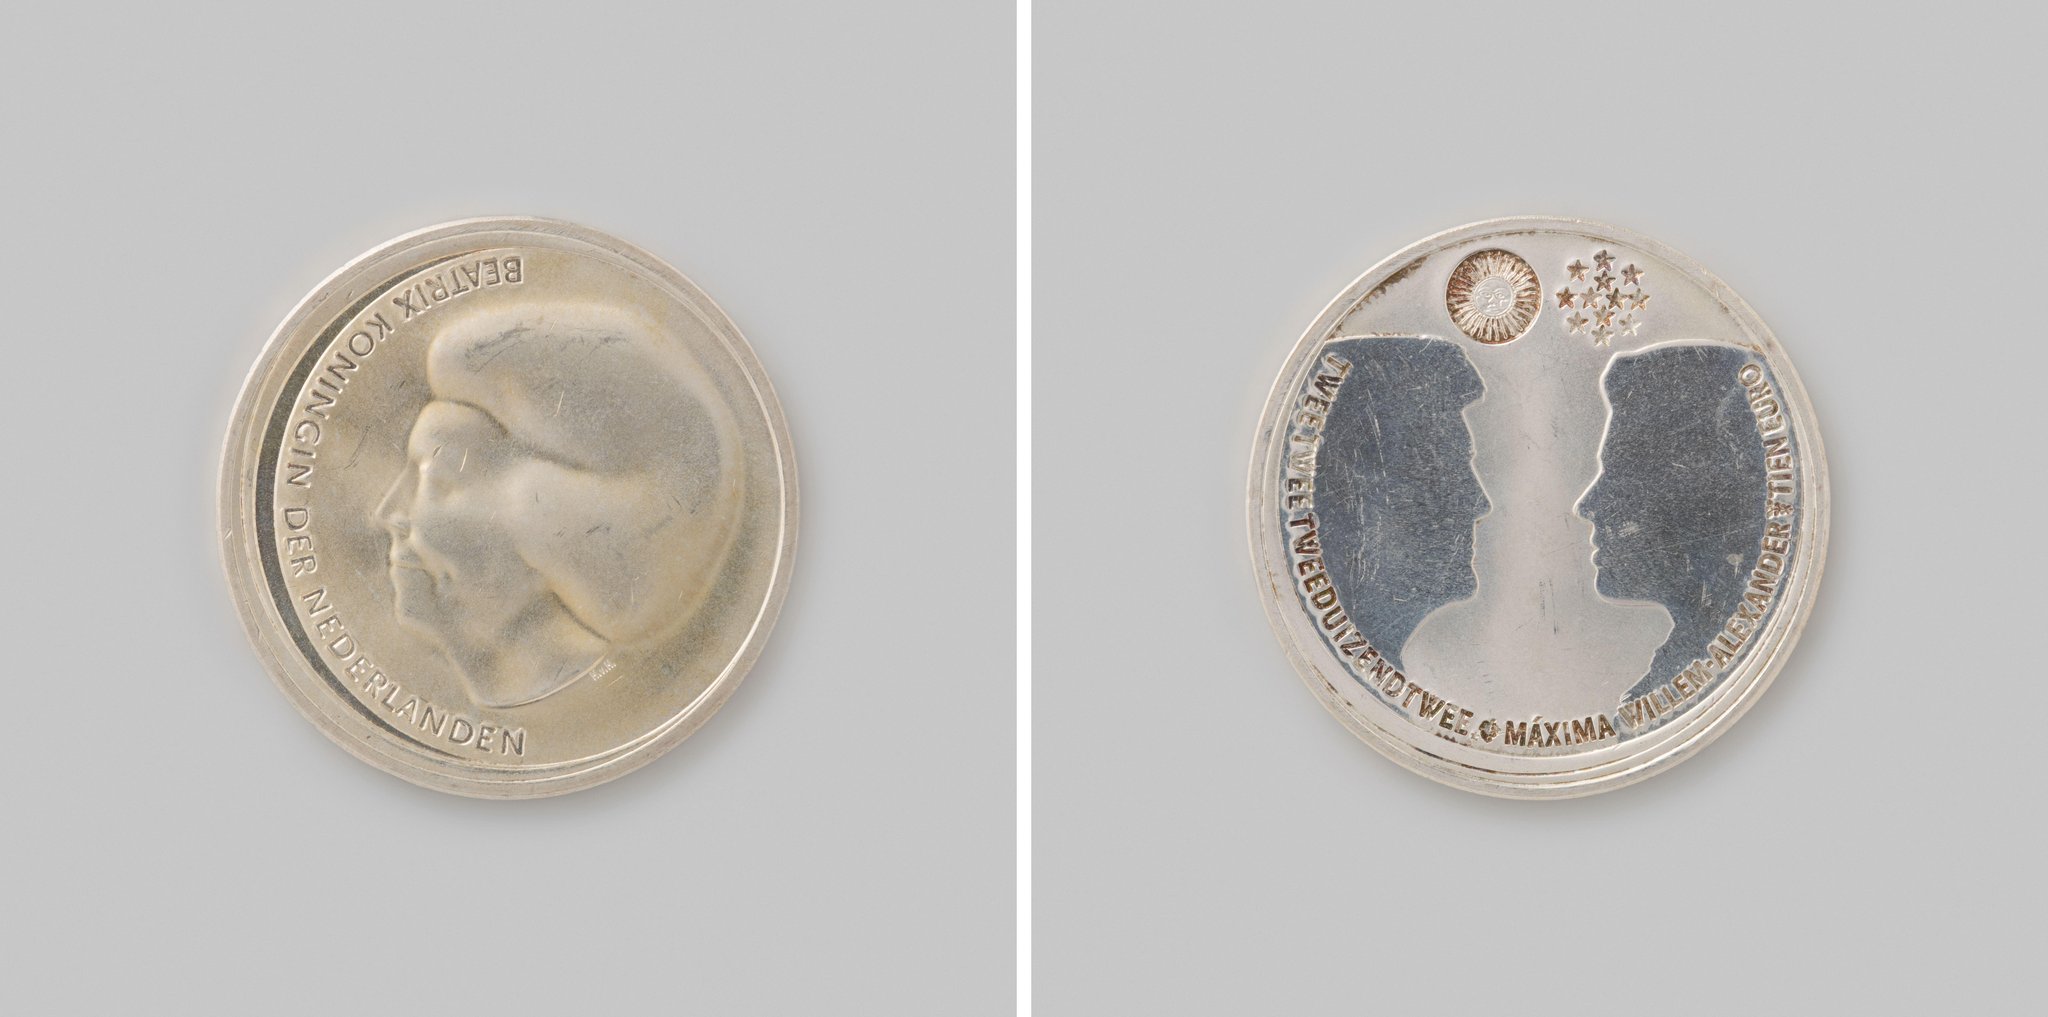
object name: coin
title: Zilveren koninklijke 10 euro huwelijksmunt Willem-Alexander en Máxima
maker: hans van houwelingen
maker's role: medailleur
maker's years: 1957-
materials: silver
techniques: striking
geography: netherlands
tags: utrecht, beatrix (koningin der nederlanden), amsterdam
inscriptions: circumscription: ‘GOD * ZIJ * MET * ONS *’, inscription: ‘BEATRIX KONINGIN DER NEDERLANDEN’, inscription: ‘TWEE TWEE TWEEDUIZEND TWEE * MÁXIMA WILLEM-ALEXANDER * TIEN EURO’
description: Zilveren huwelijksmunt ter waarde van 10 Euro, ter ere van het huwelijk van Willem-Alexander en Máxima in februari 2002. Voorzijde: portret van koningin Beatrix met omschrift. Keerzijde: de portretten van het echtpaar met de gezichten naar elkaar toe met omschrift. Daarboven twee merken: twaalf sterren en een zon. Dit is de circulatiemunt.